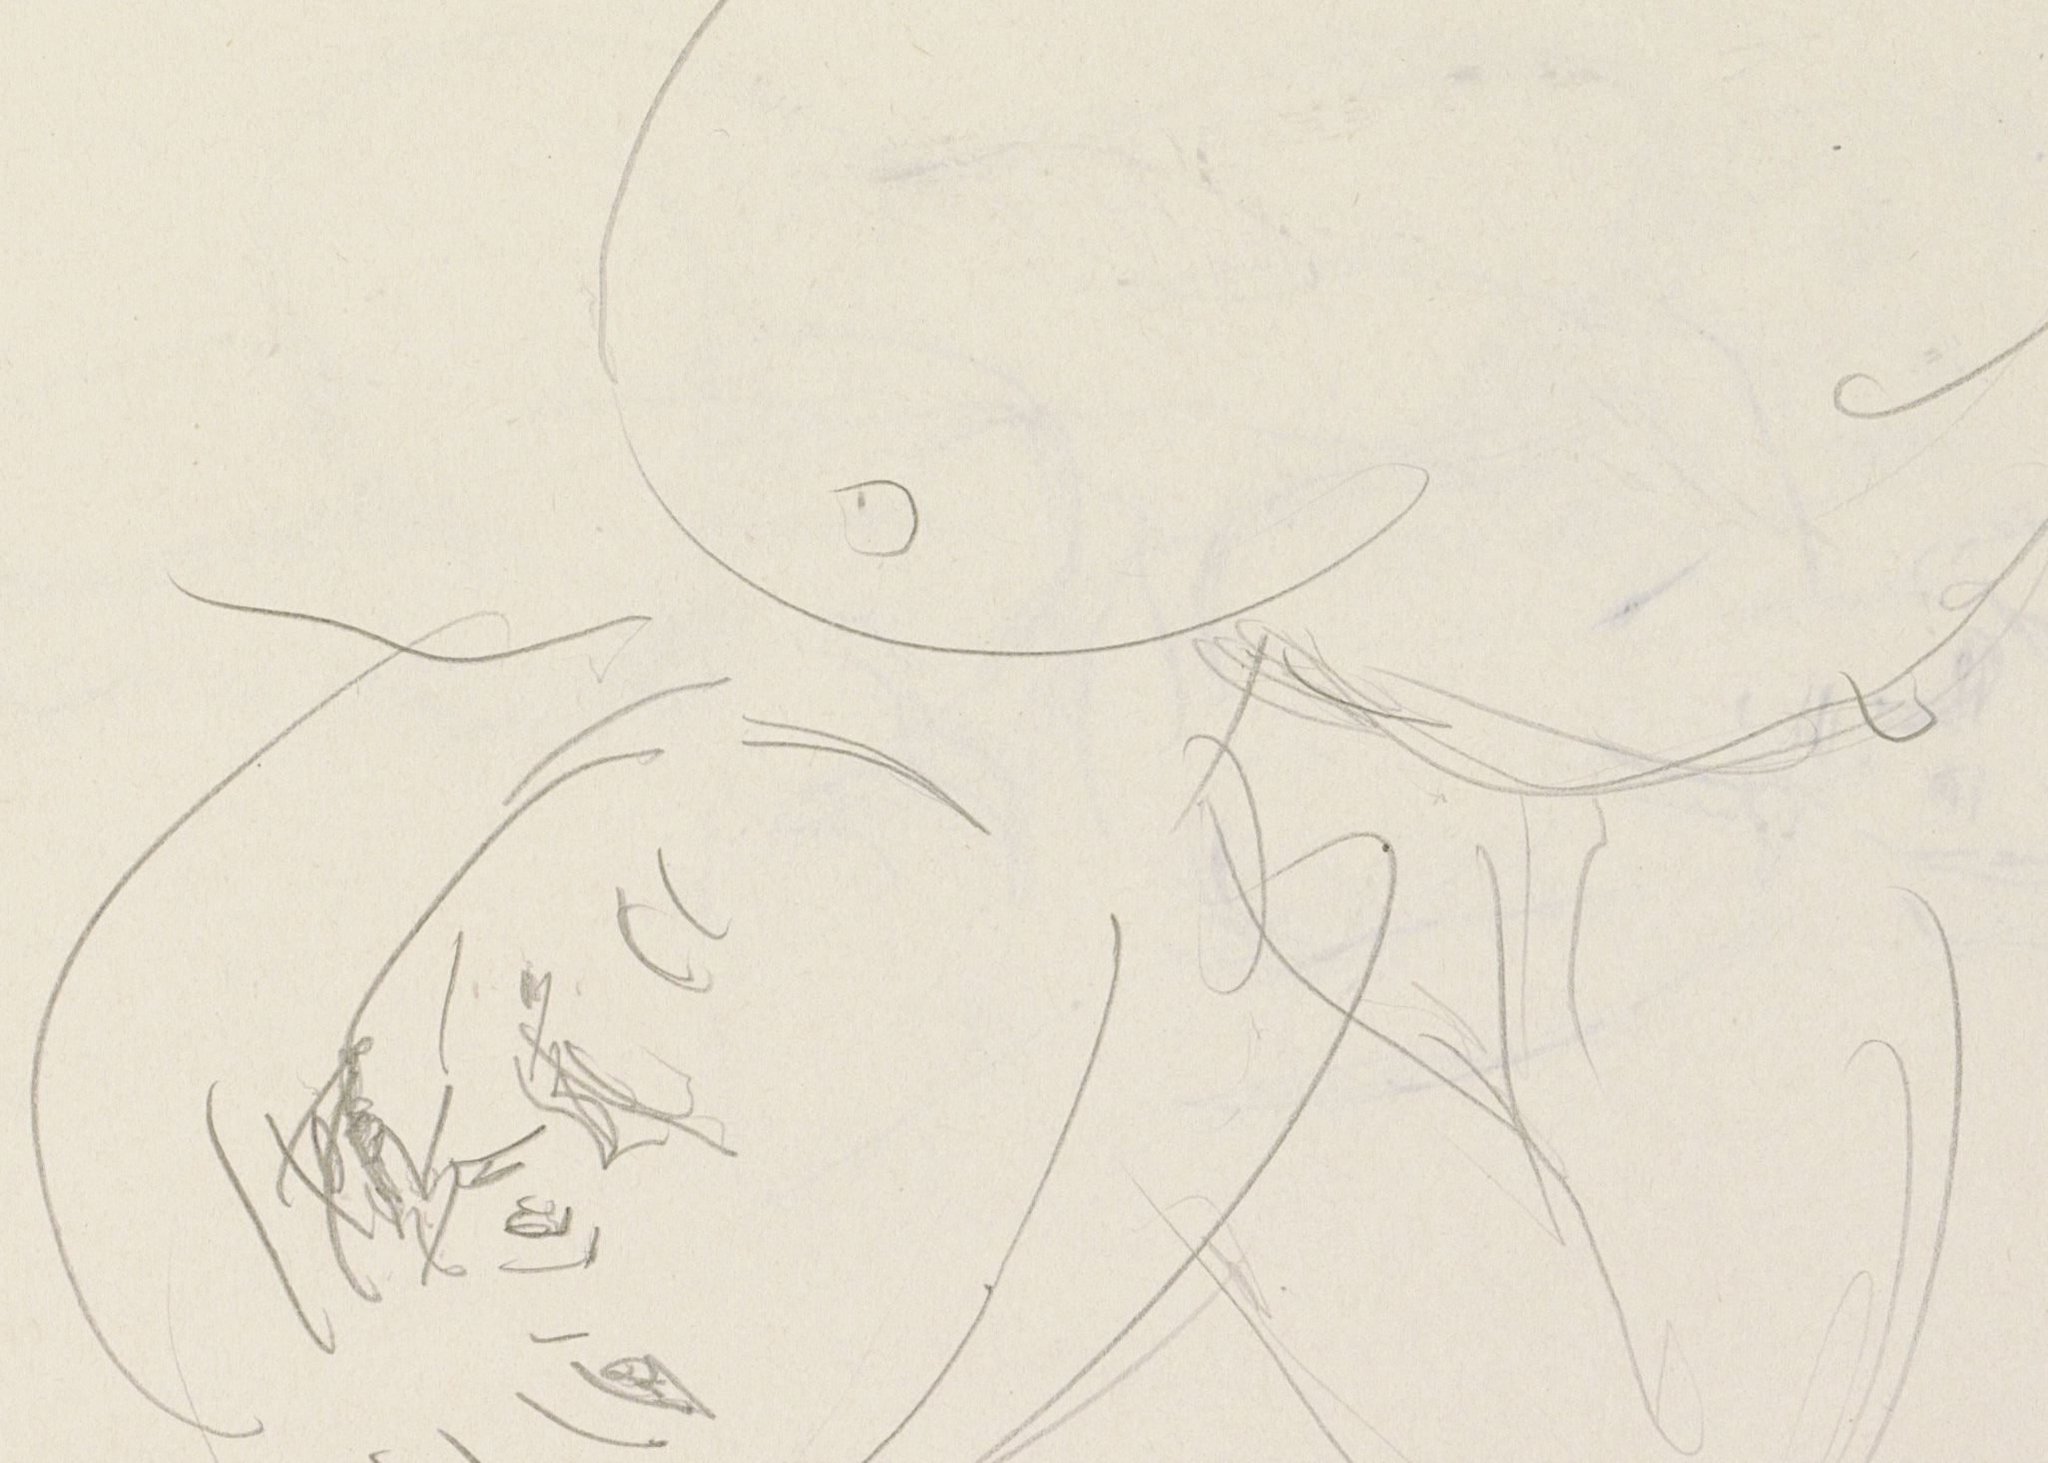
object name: sketchbook leaf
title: Reclining Female Nude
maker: isaac israels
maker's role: draughtsman, painter, print maker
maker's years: 1865-1934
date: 1875-1934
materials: paper, pencil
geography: the hague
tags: lying figure - aa - female human figure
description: Een arm onder haar hoofd. Blad 17 verso uit schetsboek II met 23 bladen.